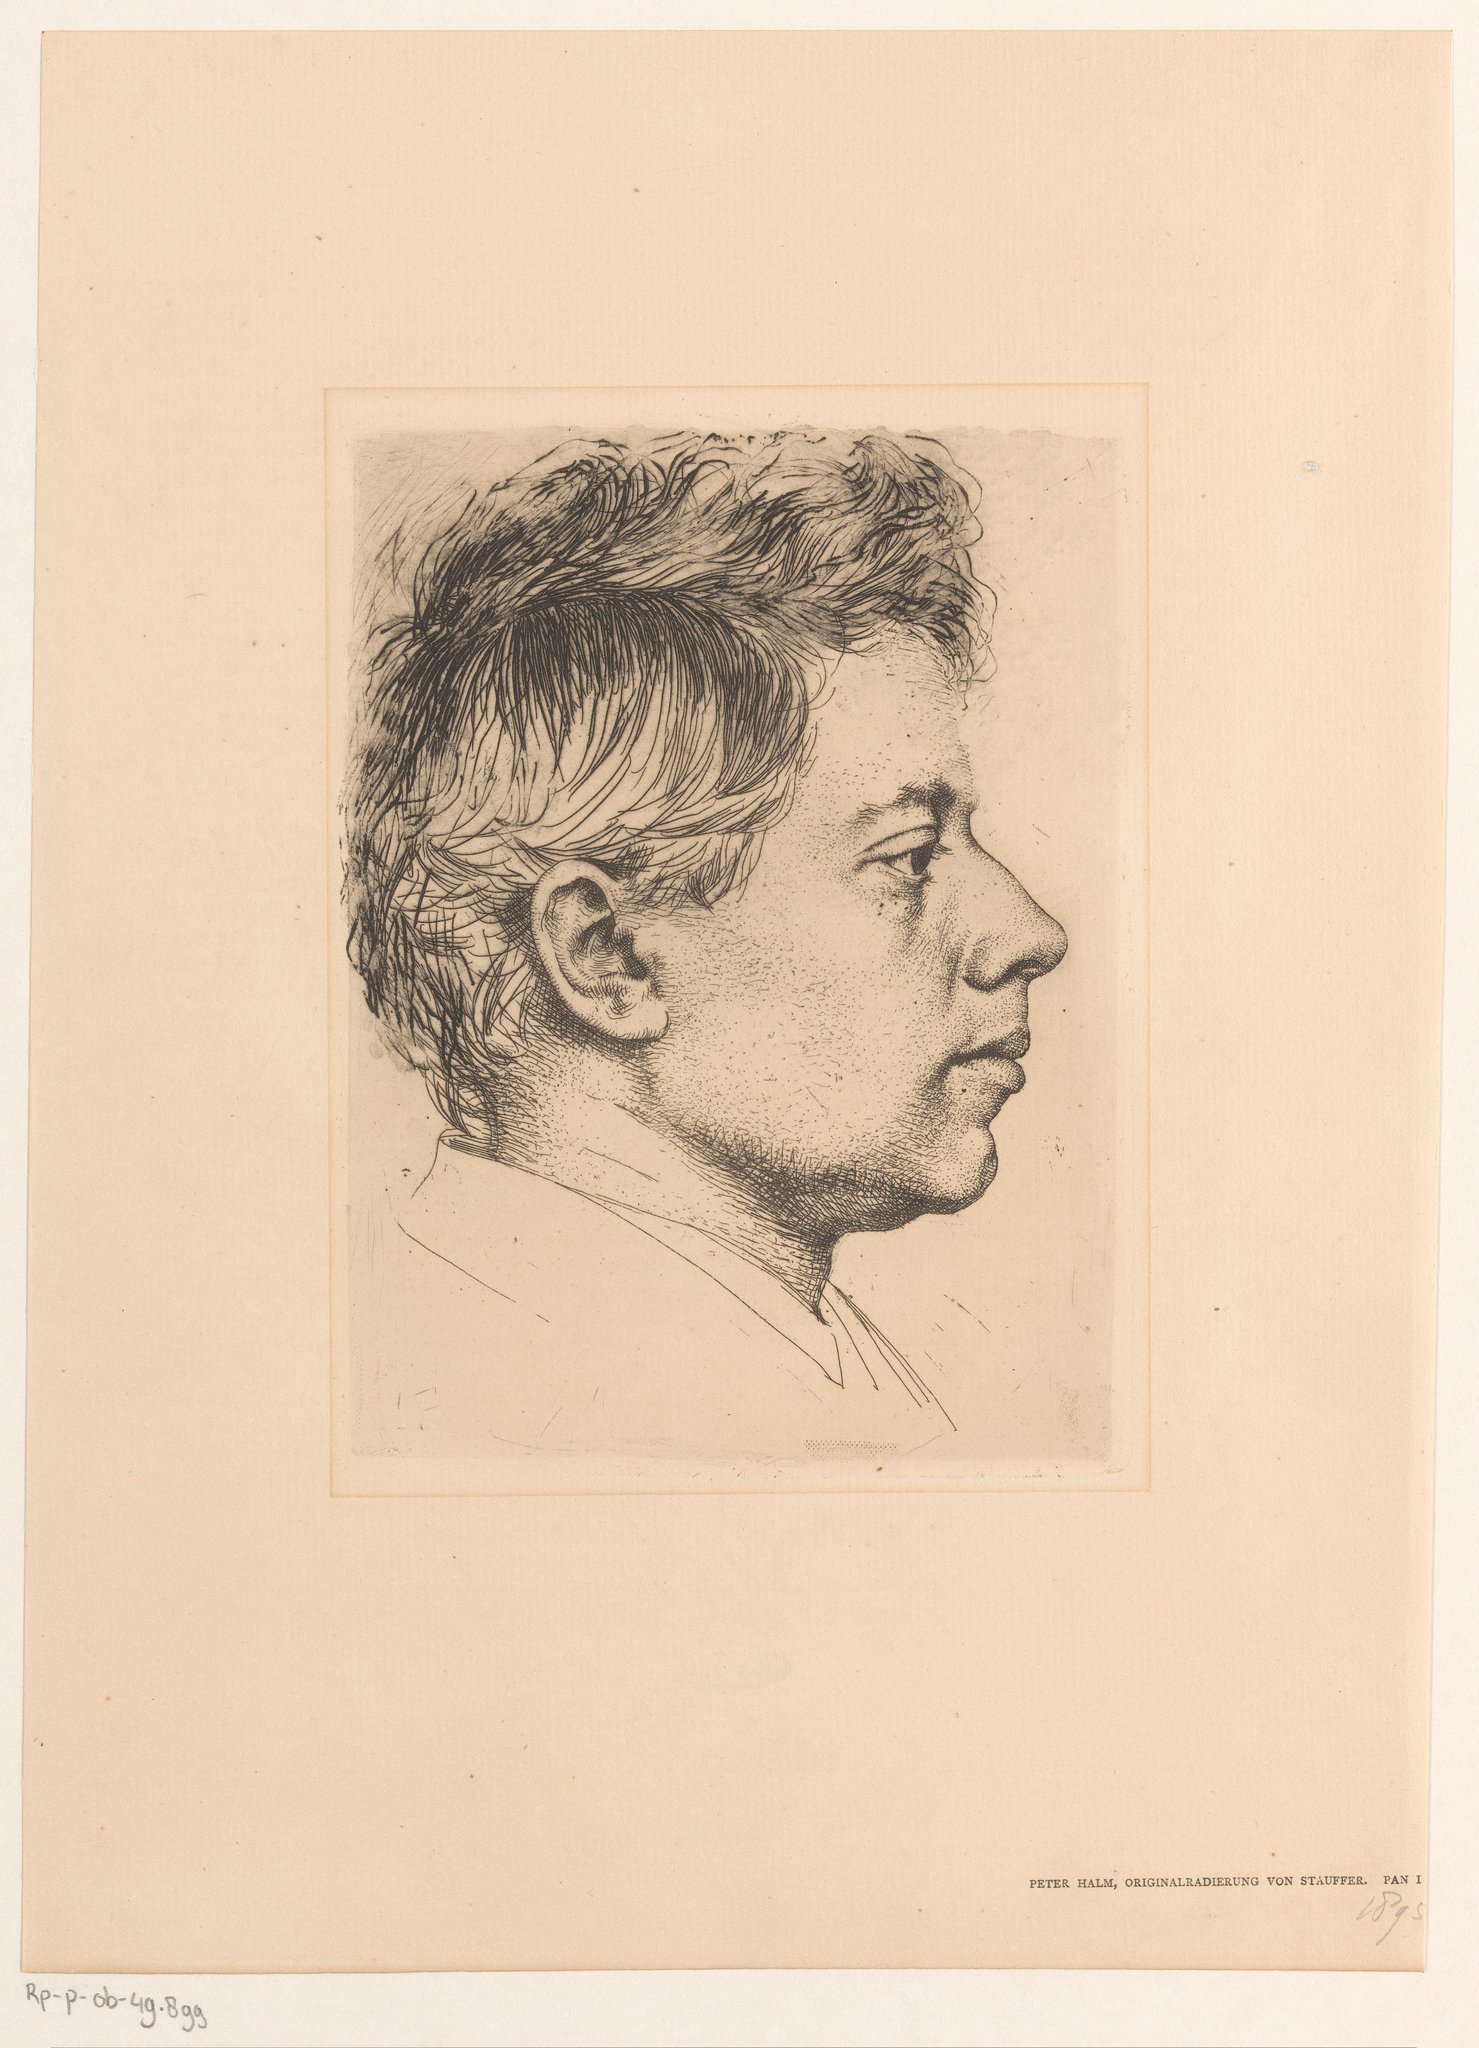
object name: print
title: Portret van Peter von Halm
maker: karl stauffer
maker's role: print maker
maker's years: 1857-1891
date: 1895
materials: paper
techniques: etching, intaglio, roulette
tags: print maker, historical persons, portrait, self-portrait of graphic artist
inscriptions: collector's mark: Lugt 2228